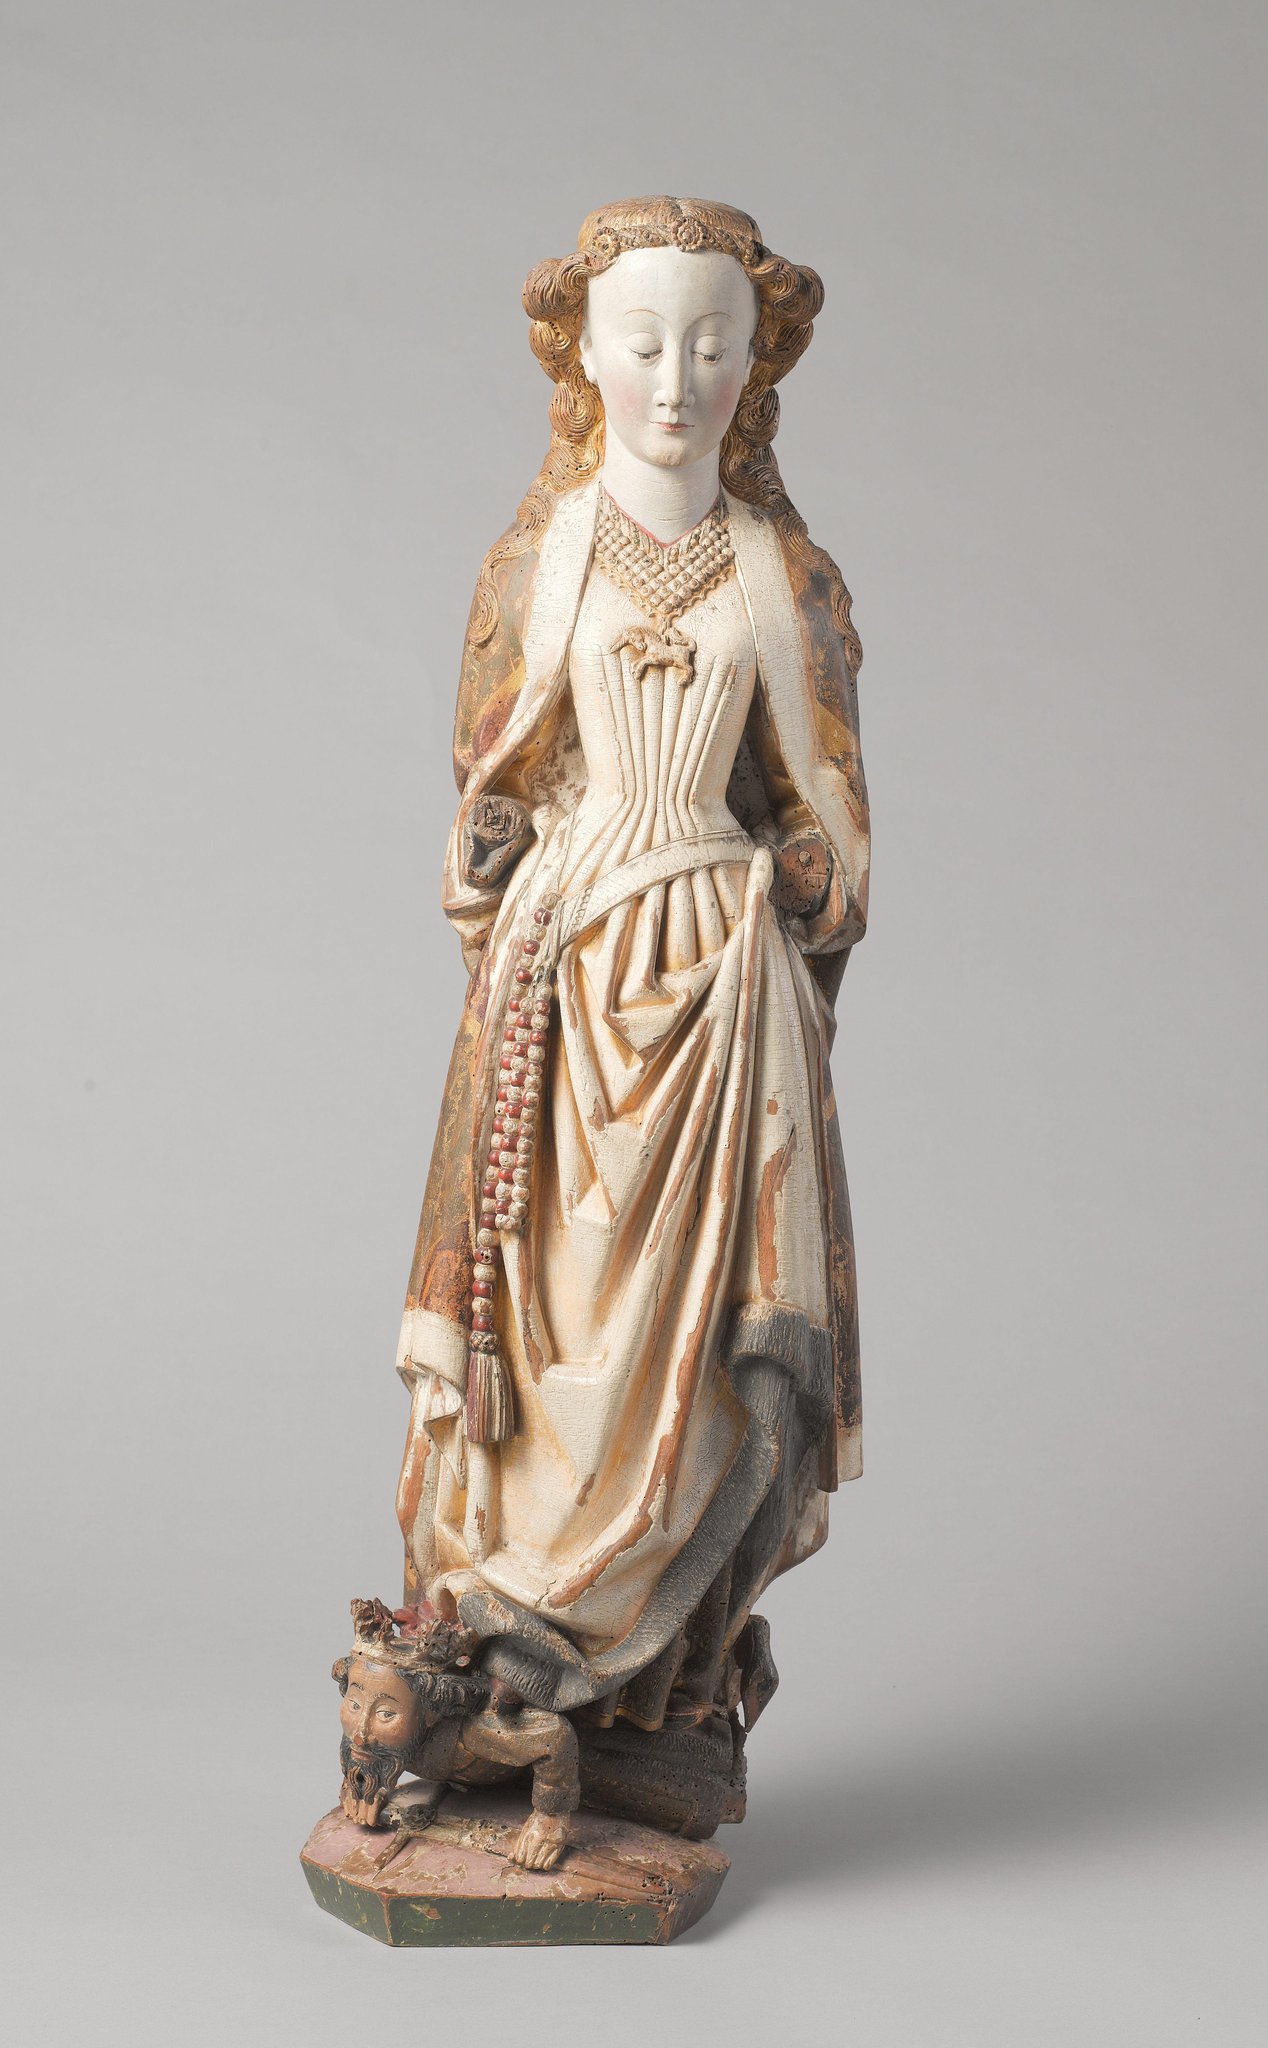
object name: figure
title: St Barbara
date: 1470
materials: wood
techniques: gilding, polychromy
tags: the virgin martyr barbara; possible attributes: book, cannon(ball), crown, cross, chalice with wafer, dioscuros (her father), peacock feather, sword, torches, mason's tools, tower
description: These three statues come from the monastery of Mariënwater in Koudewater (near ‘s Hertogenbosch). They are attributed to a sculptor who probably worked in the seclusion of the monastery. This would account for the rather old-fashioned, static and expressionless appearance of his work.